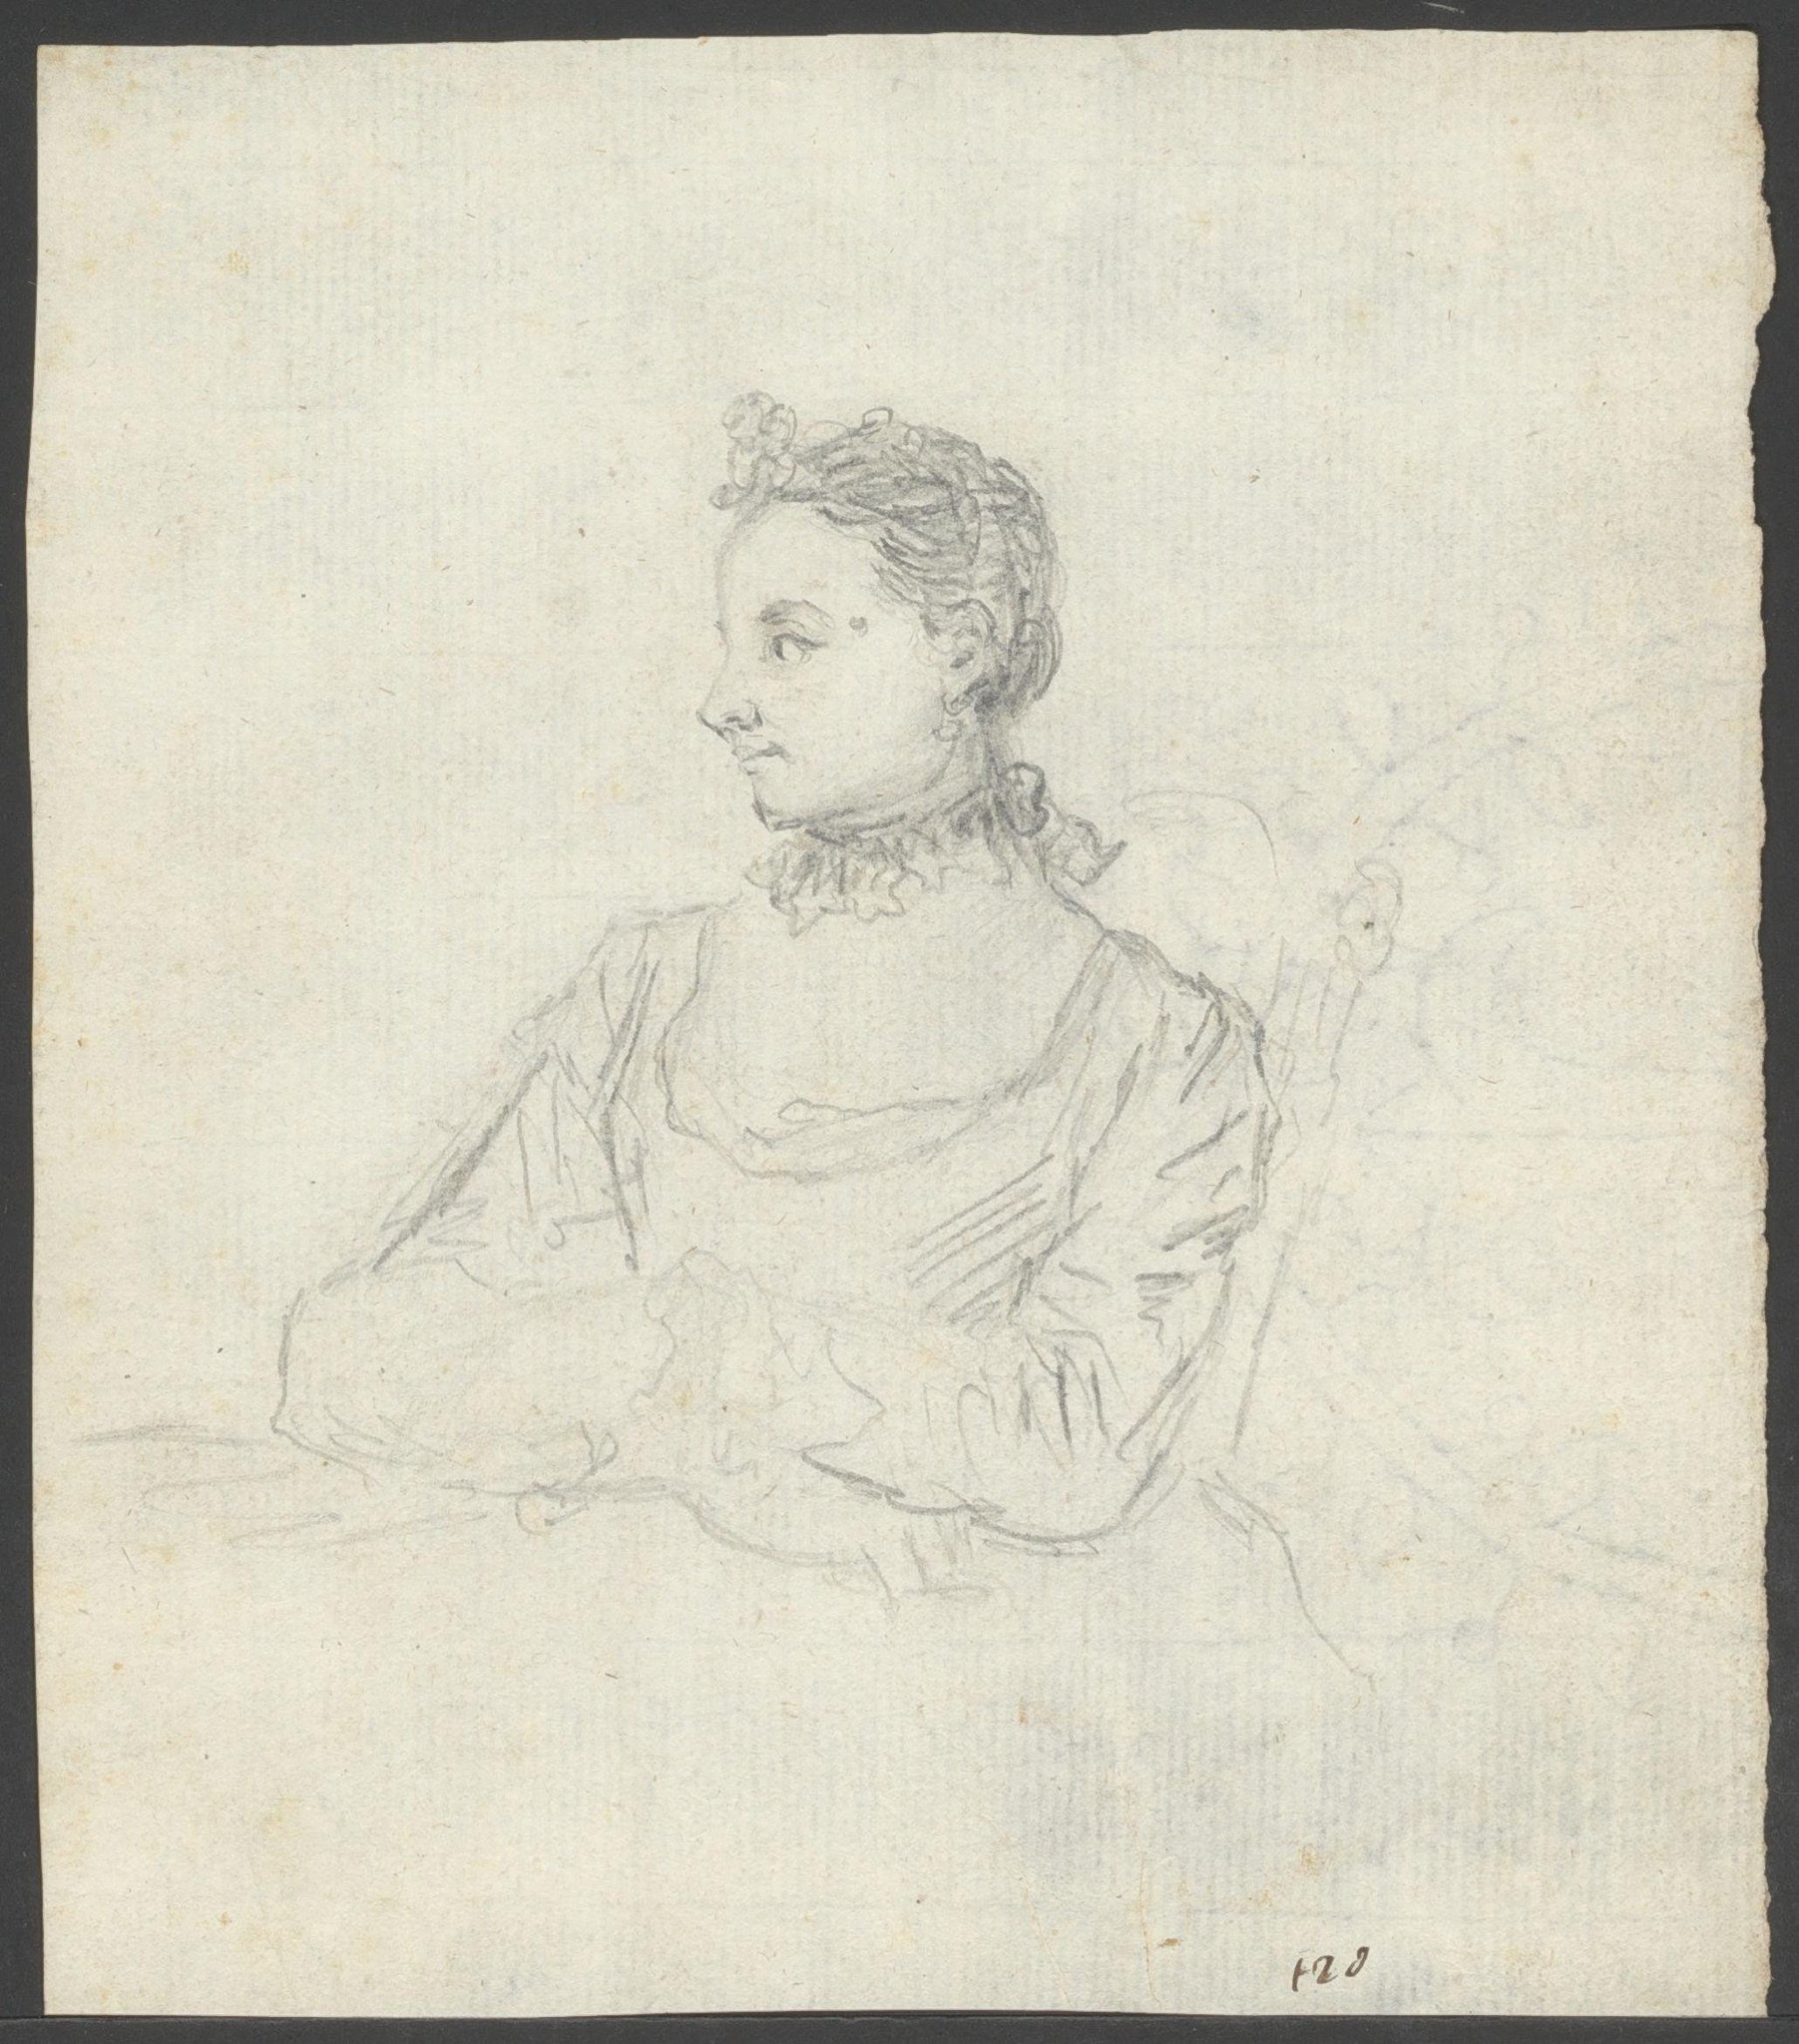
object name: drawing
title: Zittende jonge vrouw aan tafel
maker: jean bernard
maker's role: draughtsman, print maker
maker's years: 1765-1833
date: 1775-1833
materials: chalk, paper, pencil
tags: adolescent, young woman, maiden, table, chair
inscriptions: stamp, collector's mark: Lugt 1641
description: Onderwerpsrubrieken binnen de Atlas Zeden en Gewoonten: Schoone kunsten, Schilderkunst, Tekeningen.